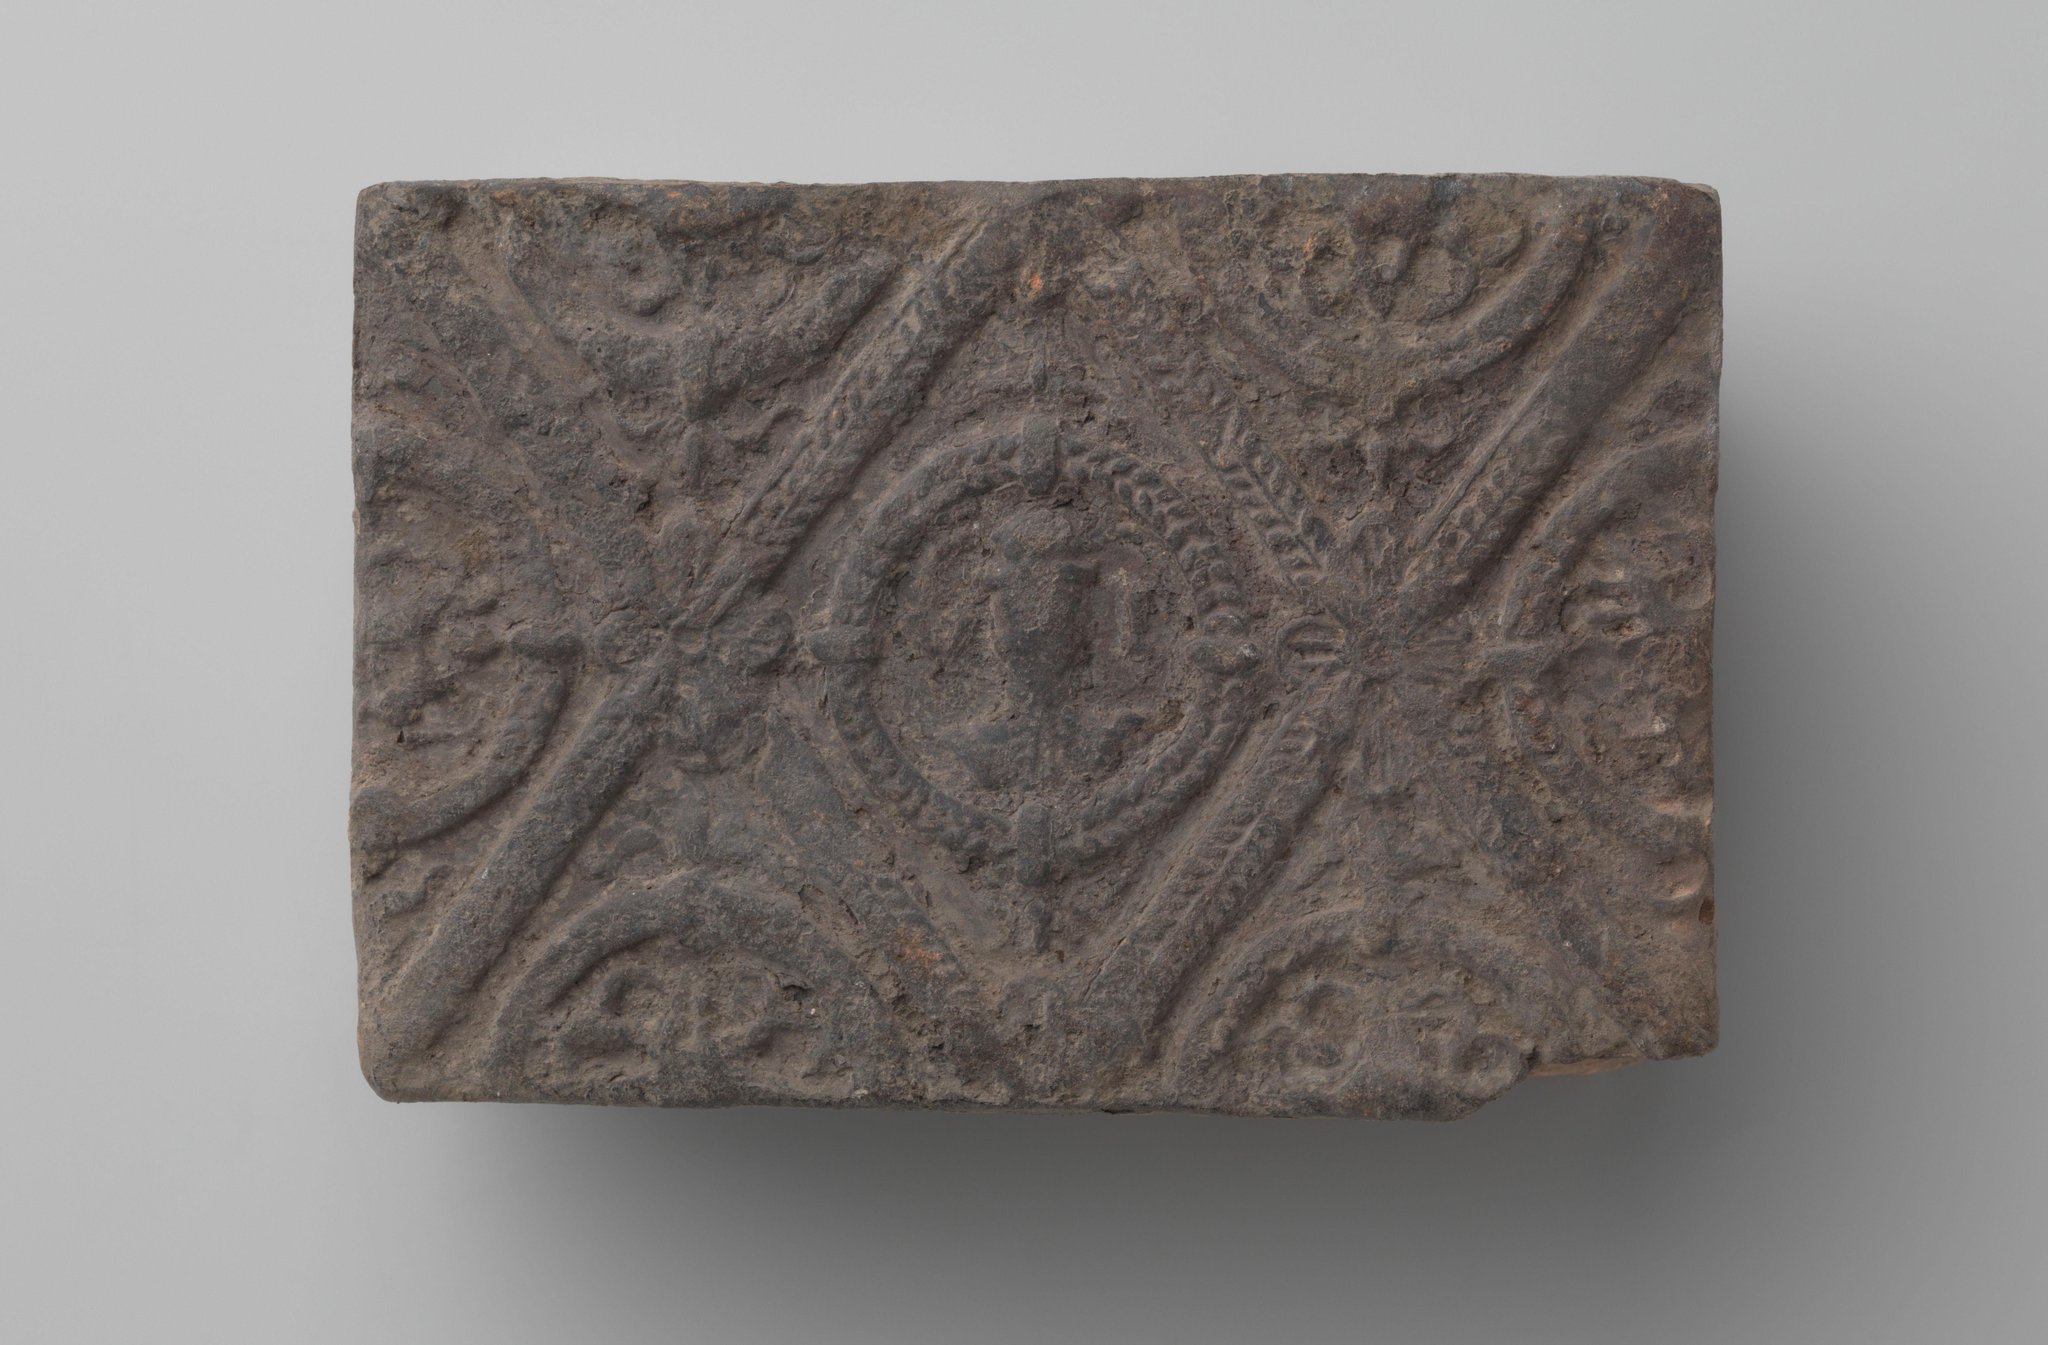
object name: hearthstone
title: Haardsteen met mannenkop en de letters V I in lauwerkrans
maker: Anonymous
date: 1575-1625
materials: earthenware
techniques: printing, firing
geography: southern netherlands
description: Haardsteen met voorstelling van mannenkop en de letters V I in lauwerkrans, geplaatst in geprofileerde ruit. In de halve ruiten aan de zijkanten een dubbelkoppige adelaar. De halve ruiten aan de boven- en onderkant zijn opgevuld met halve medaillons met stermotief.